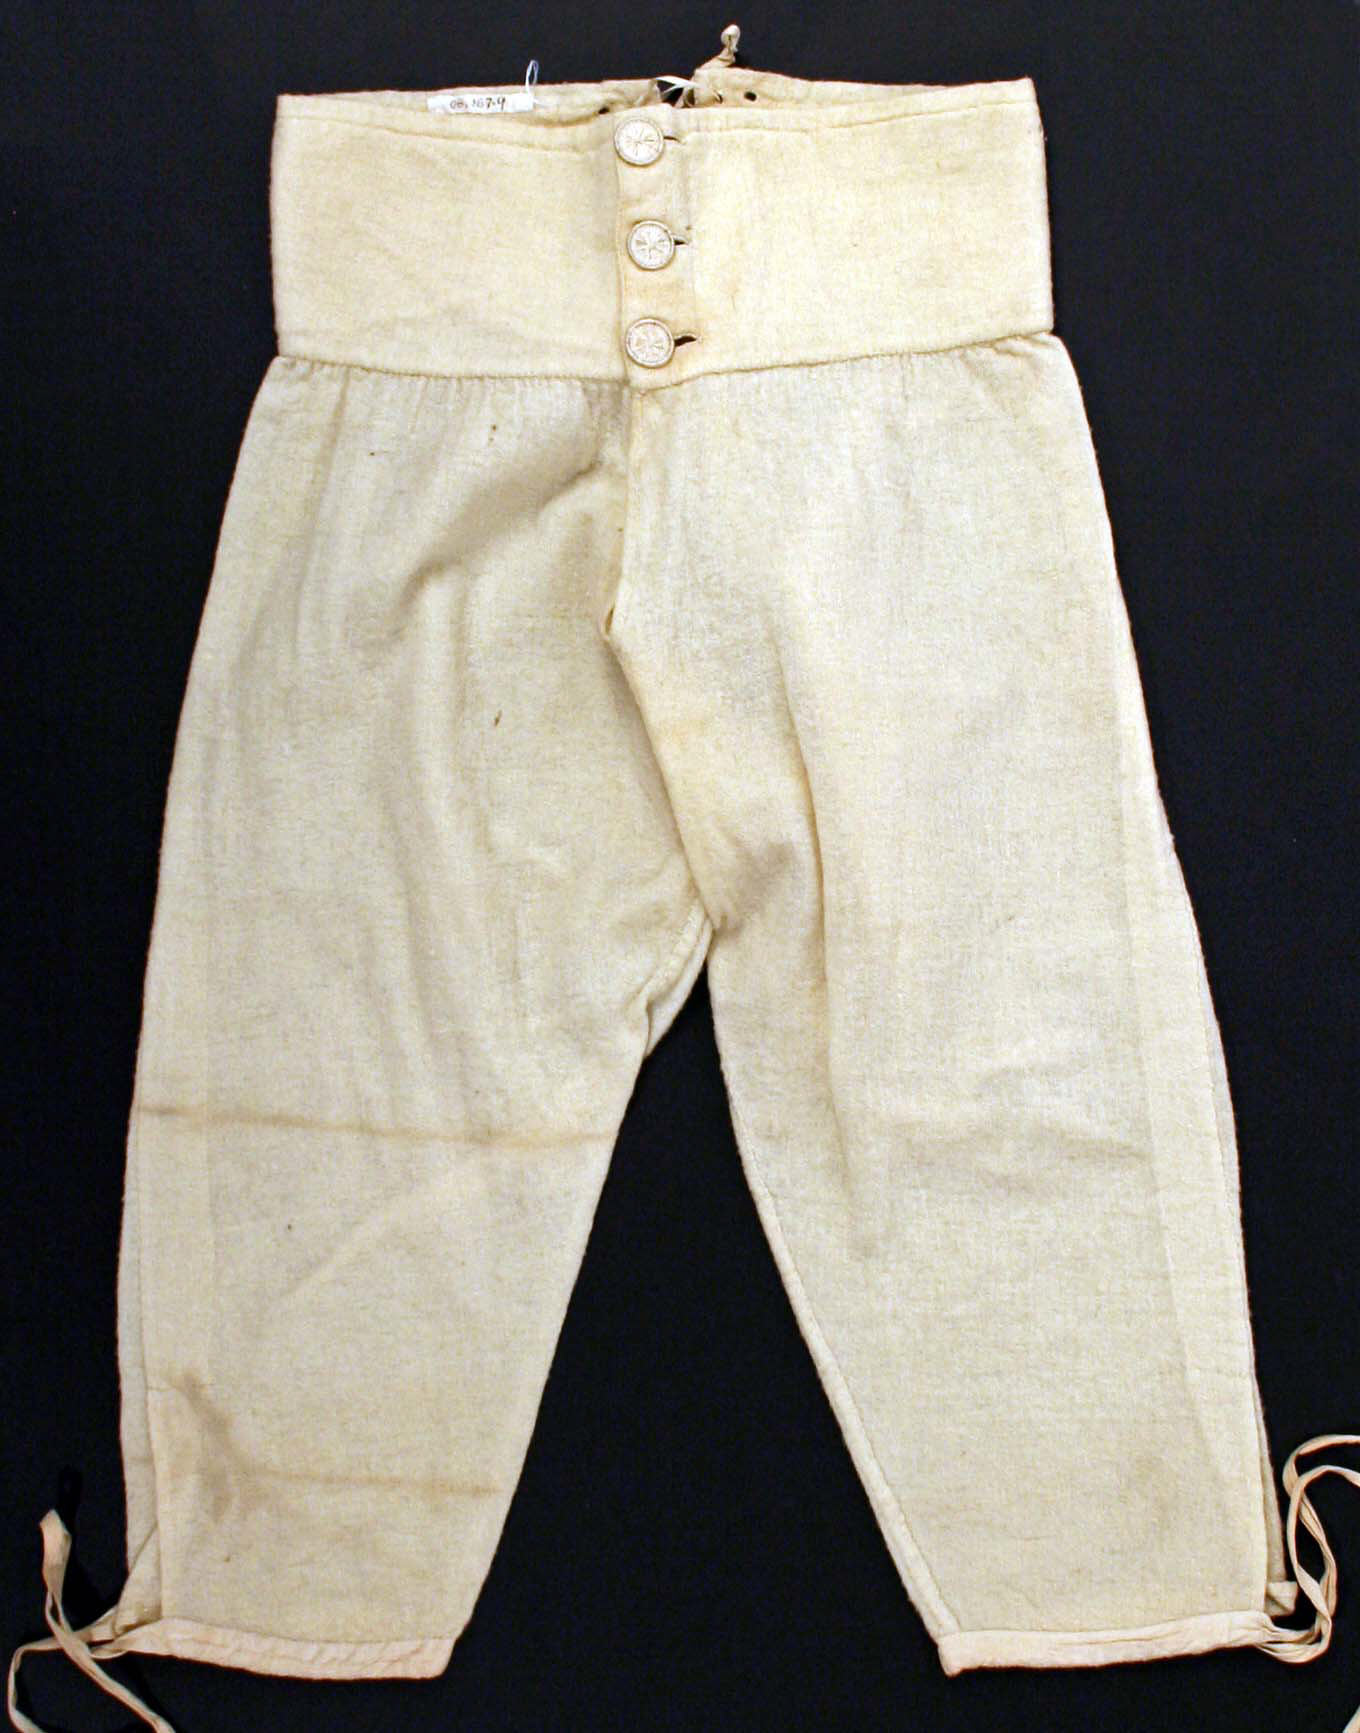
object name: drawer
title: Drawers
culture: british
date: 1801-1833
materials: wool